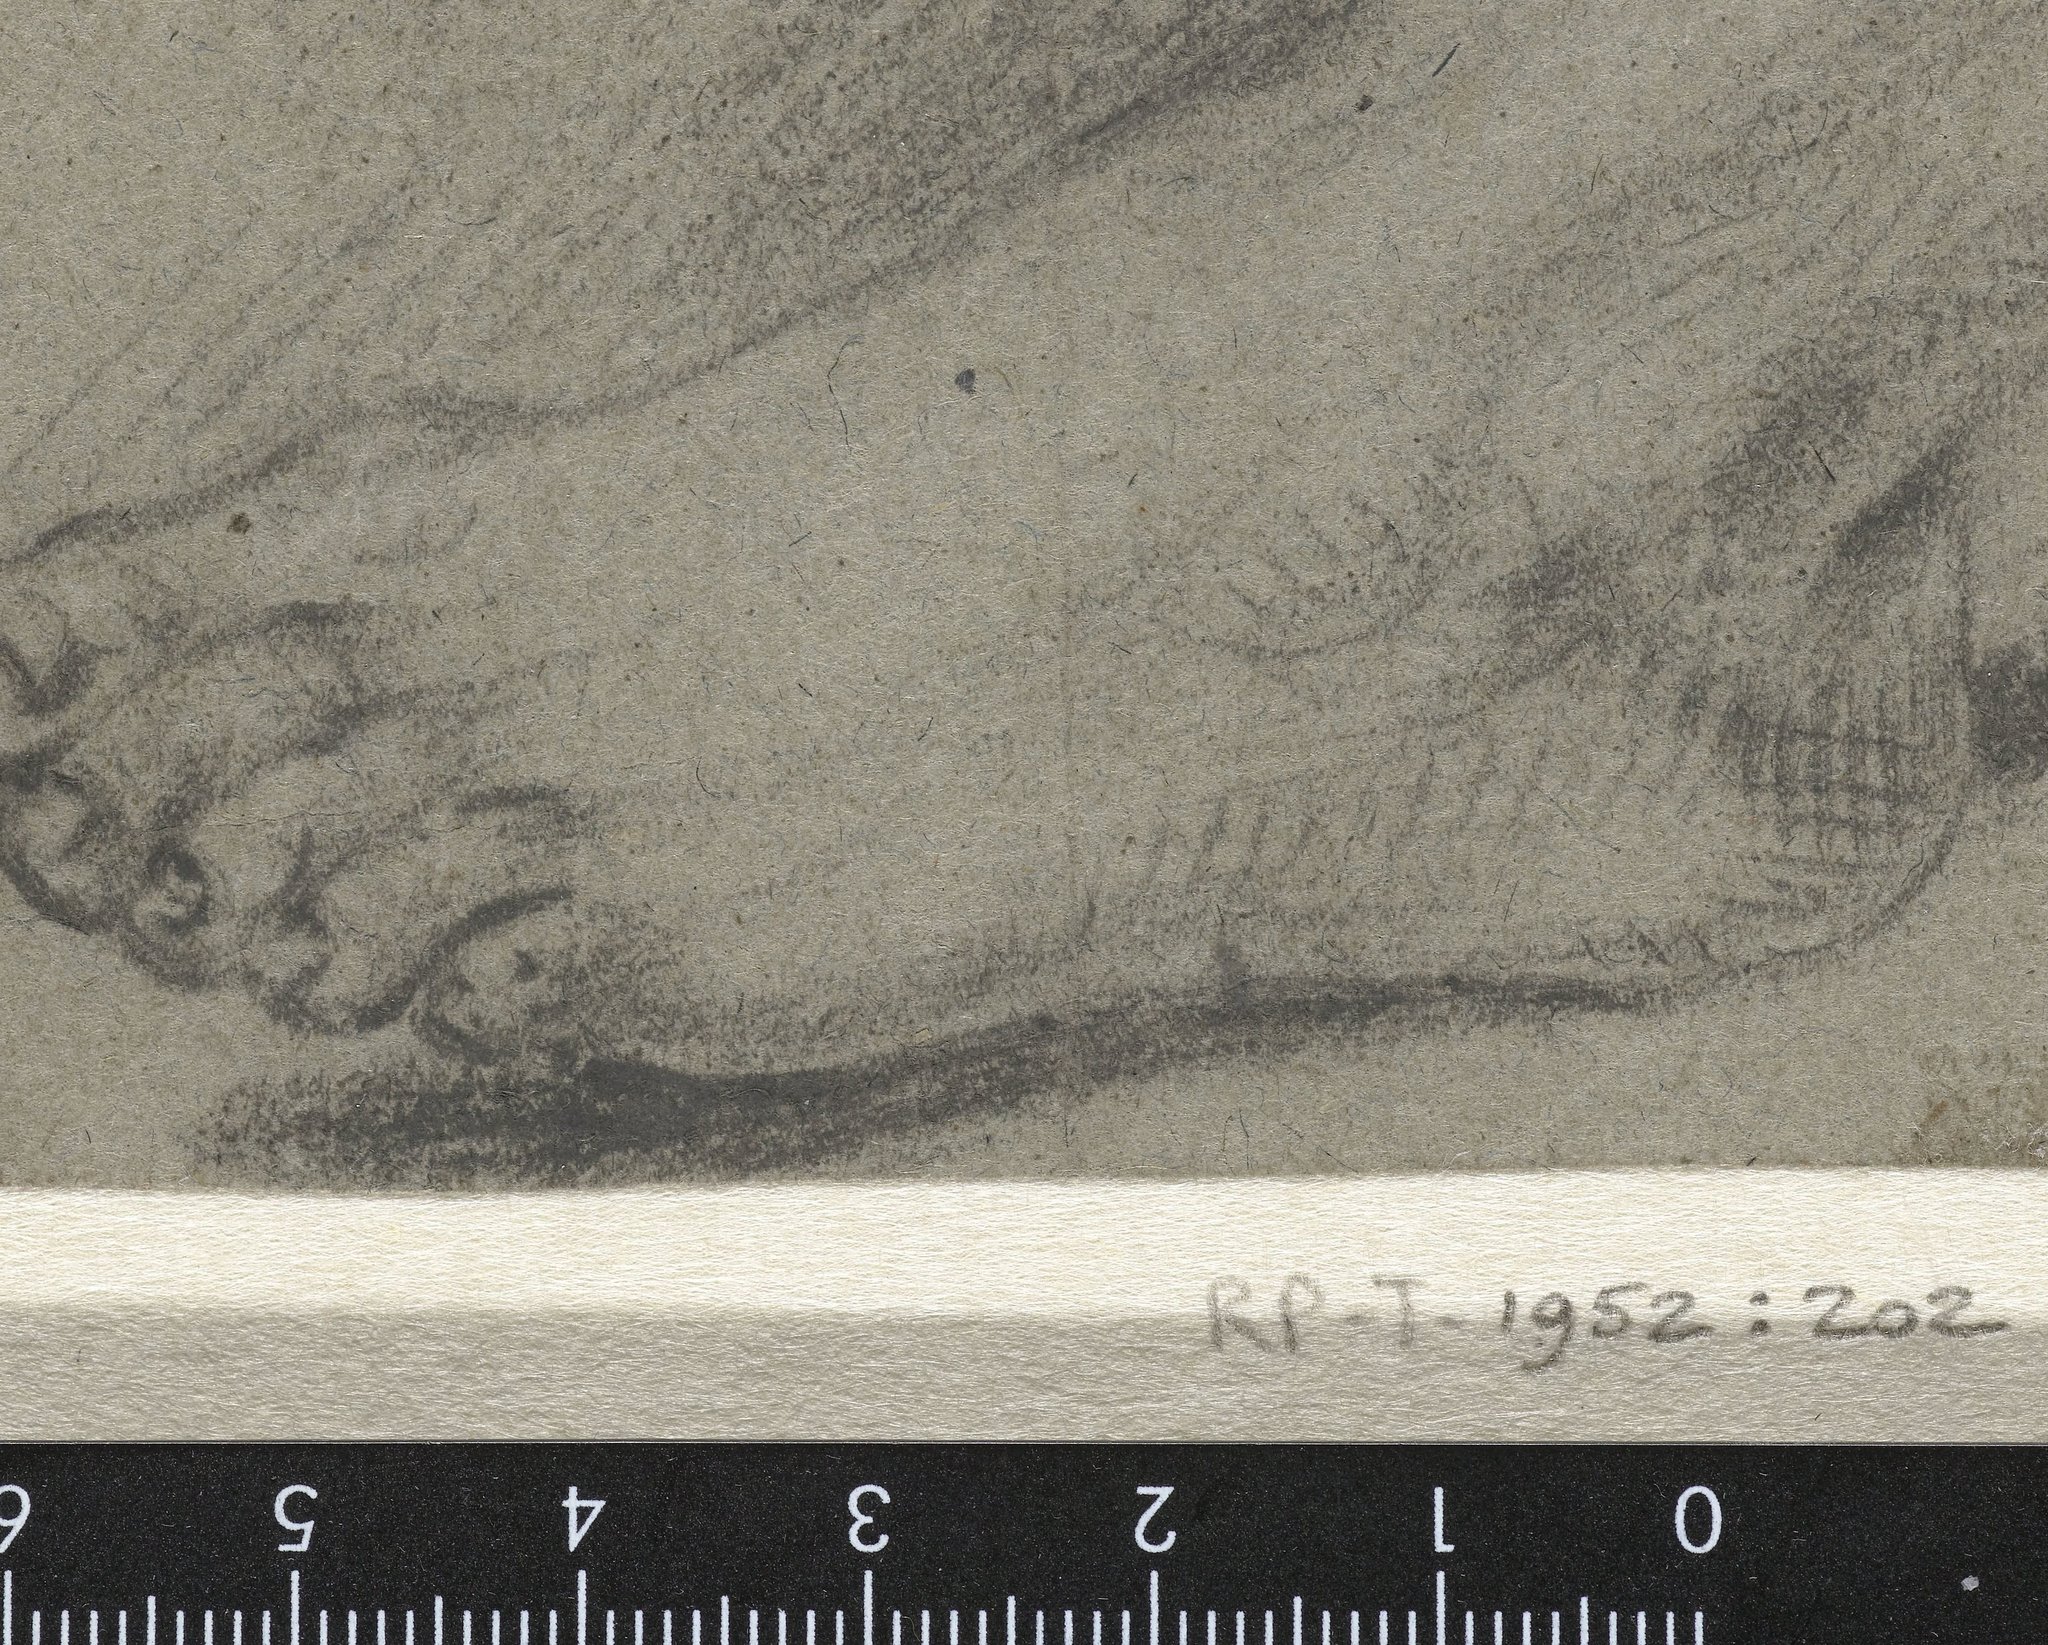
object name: drawing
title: Studie van een linkervoet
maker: simon andreas krausz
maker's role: draughtsman, print maker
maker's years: 1760-1825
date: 1770-1825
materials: chalk, paper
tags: foot